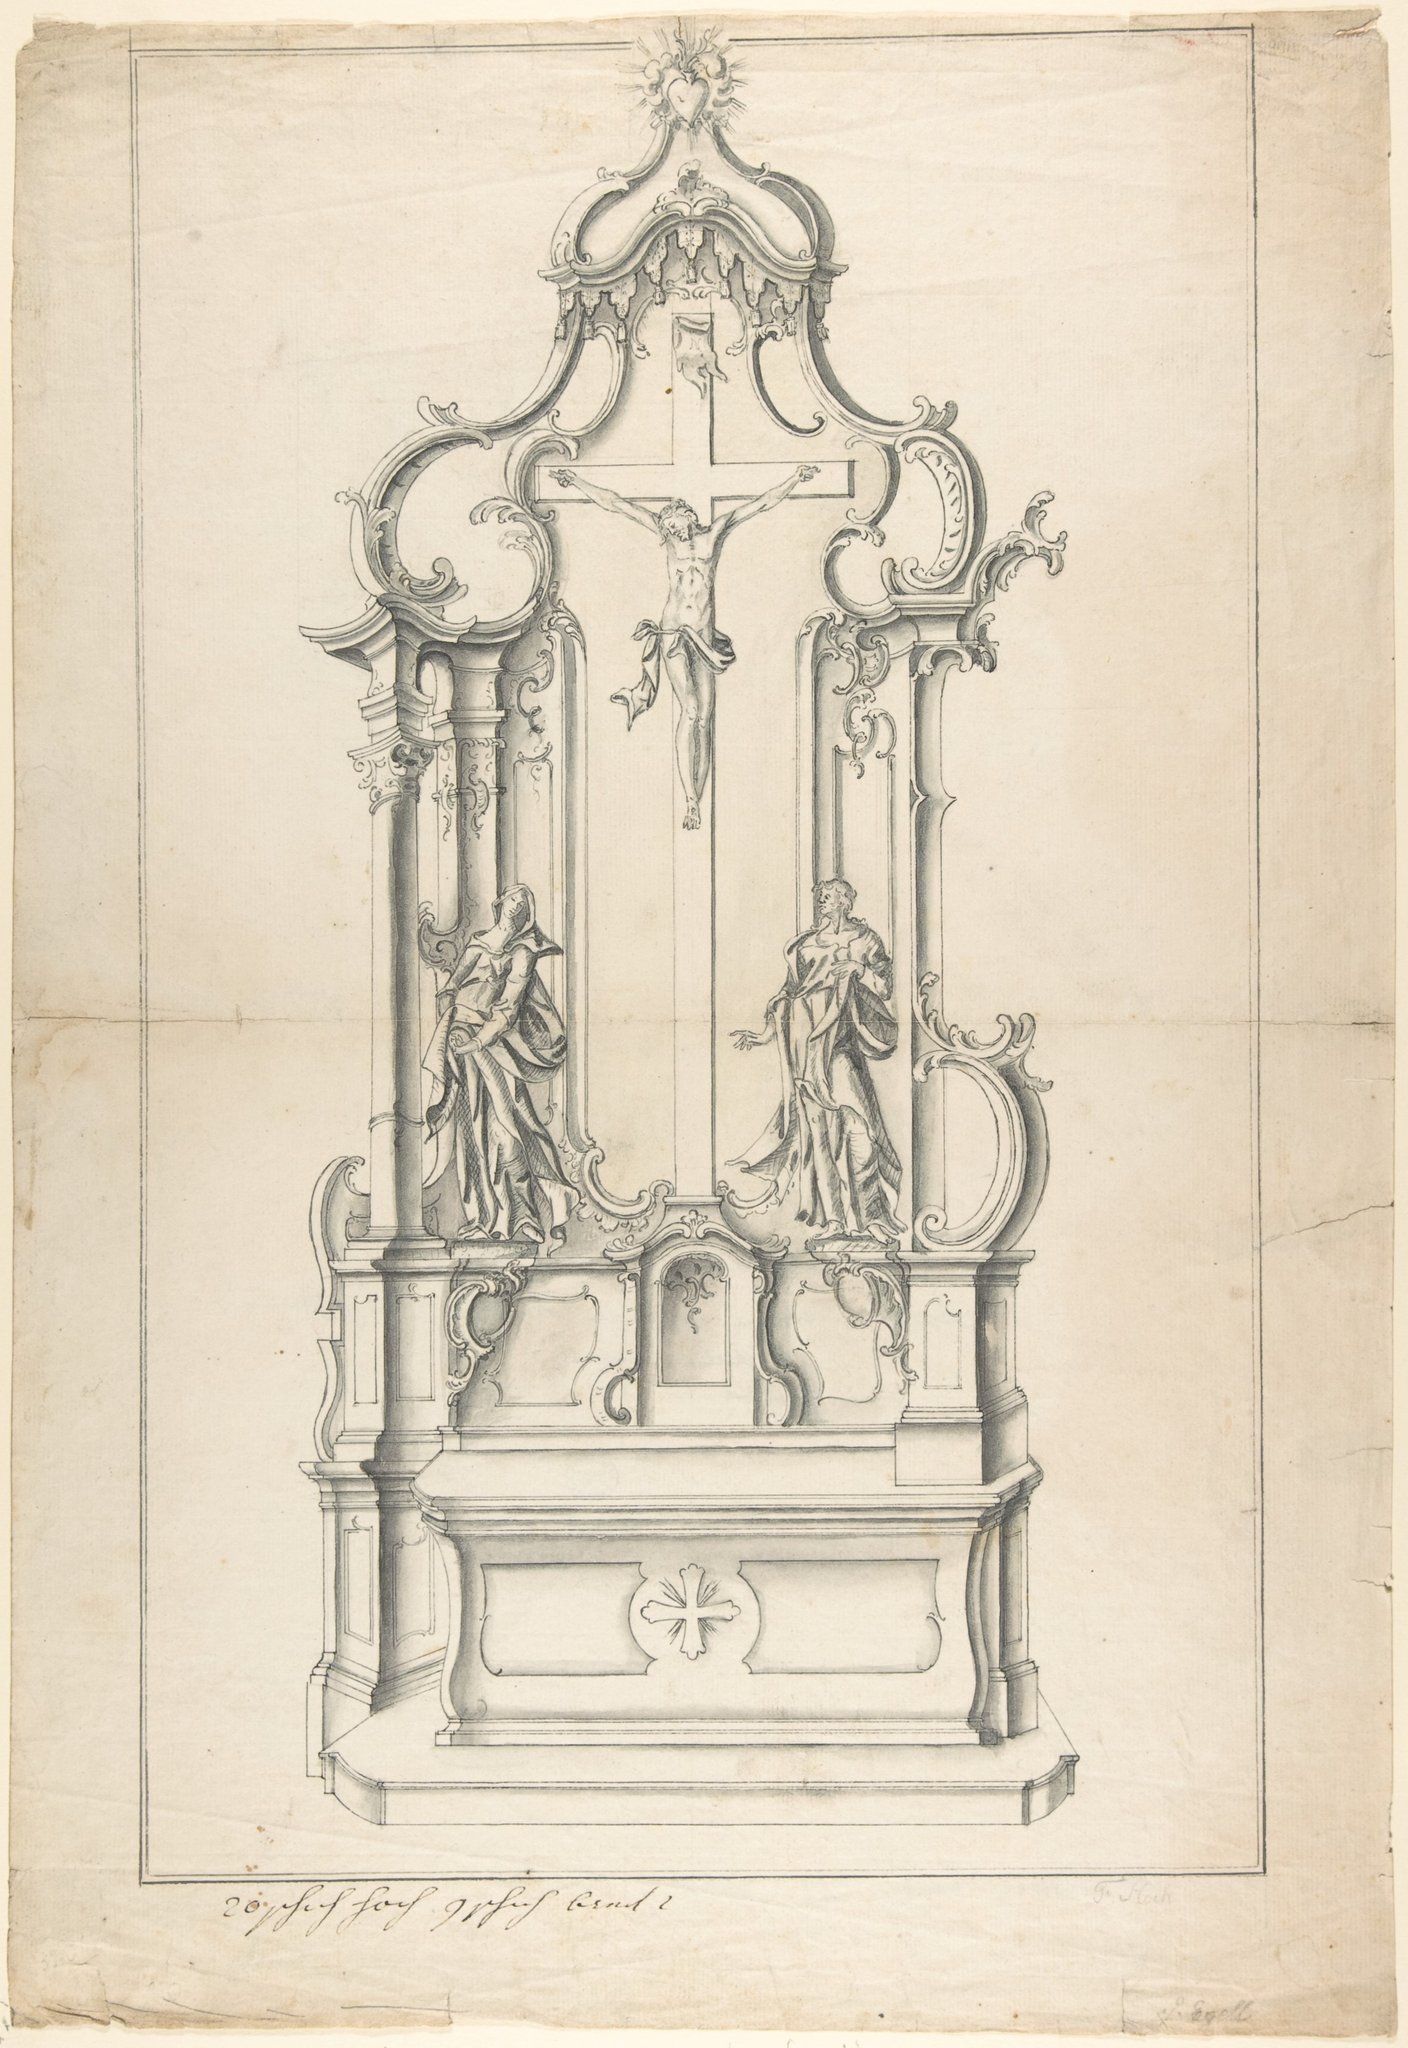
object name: drawing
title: Design for an Altar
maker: anonymous, german, 19th century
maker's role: artist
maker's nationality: german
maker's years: 1800-1899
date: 1801-1900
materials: ink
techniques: brush, pen, wash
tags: altars,christ,crucifixion